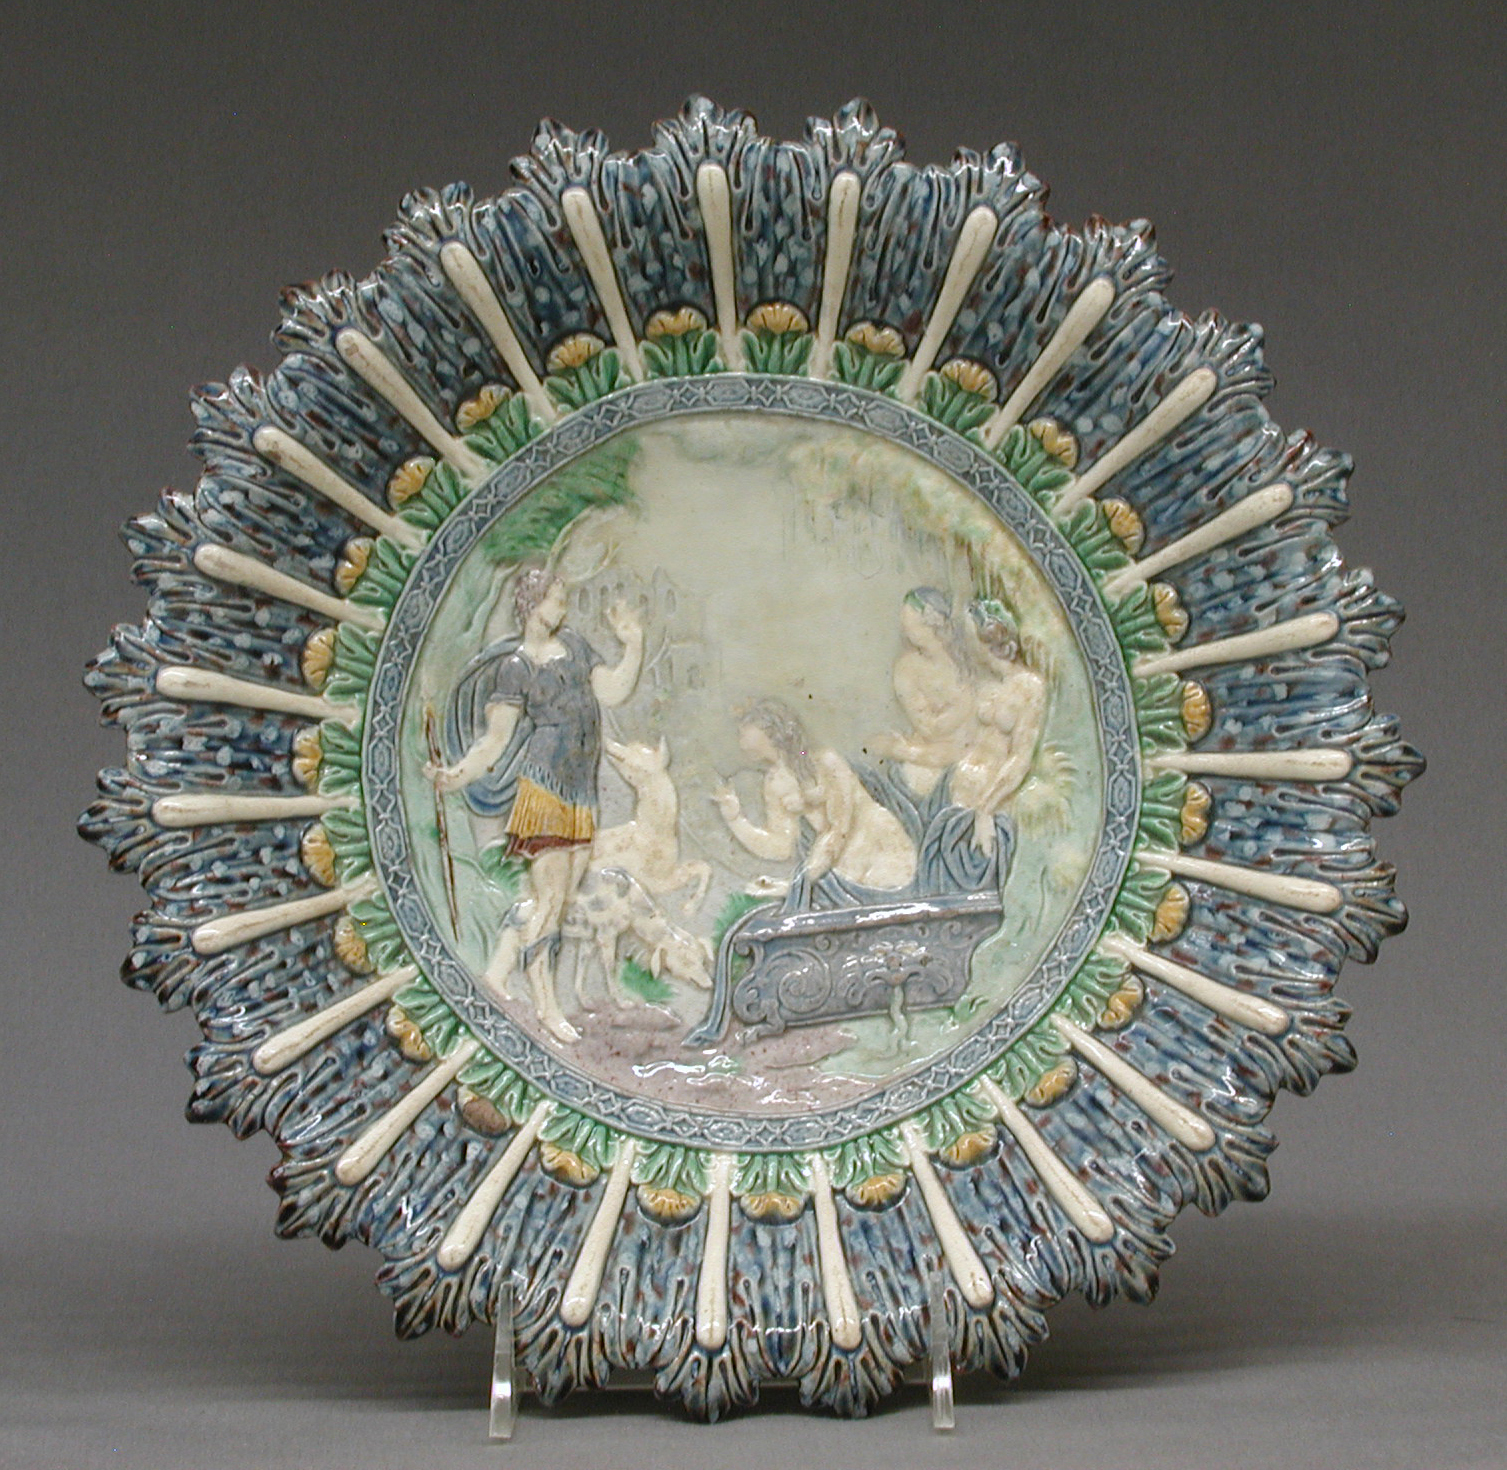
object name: dish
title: Dish with Acteon changed into a stag by Diana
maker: bernard palissy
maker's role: maker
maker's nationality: french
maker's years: 1510-1590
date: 1601-1700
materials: earthenware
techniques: glazing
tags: diana